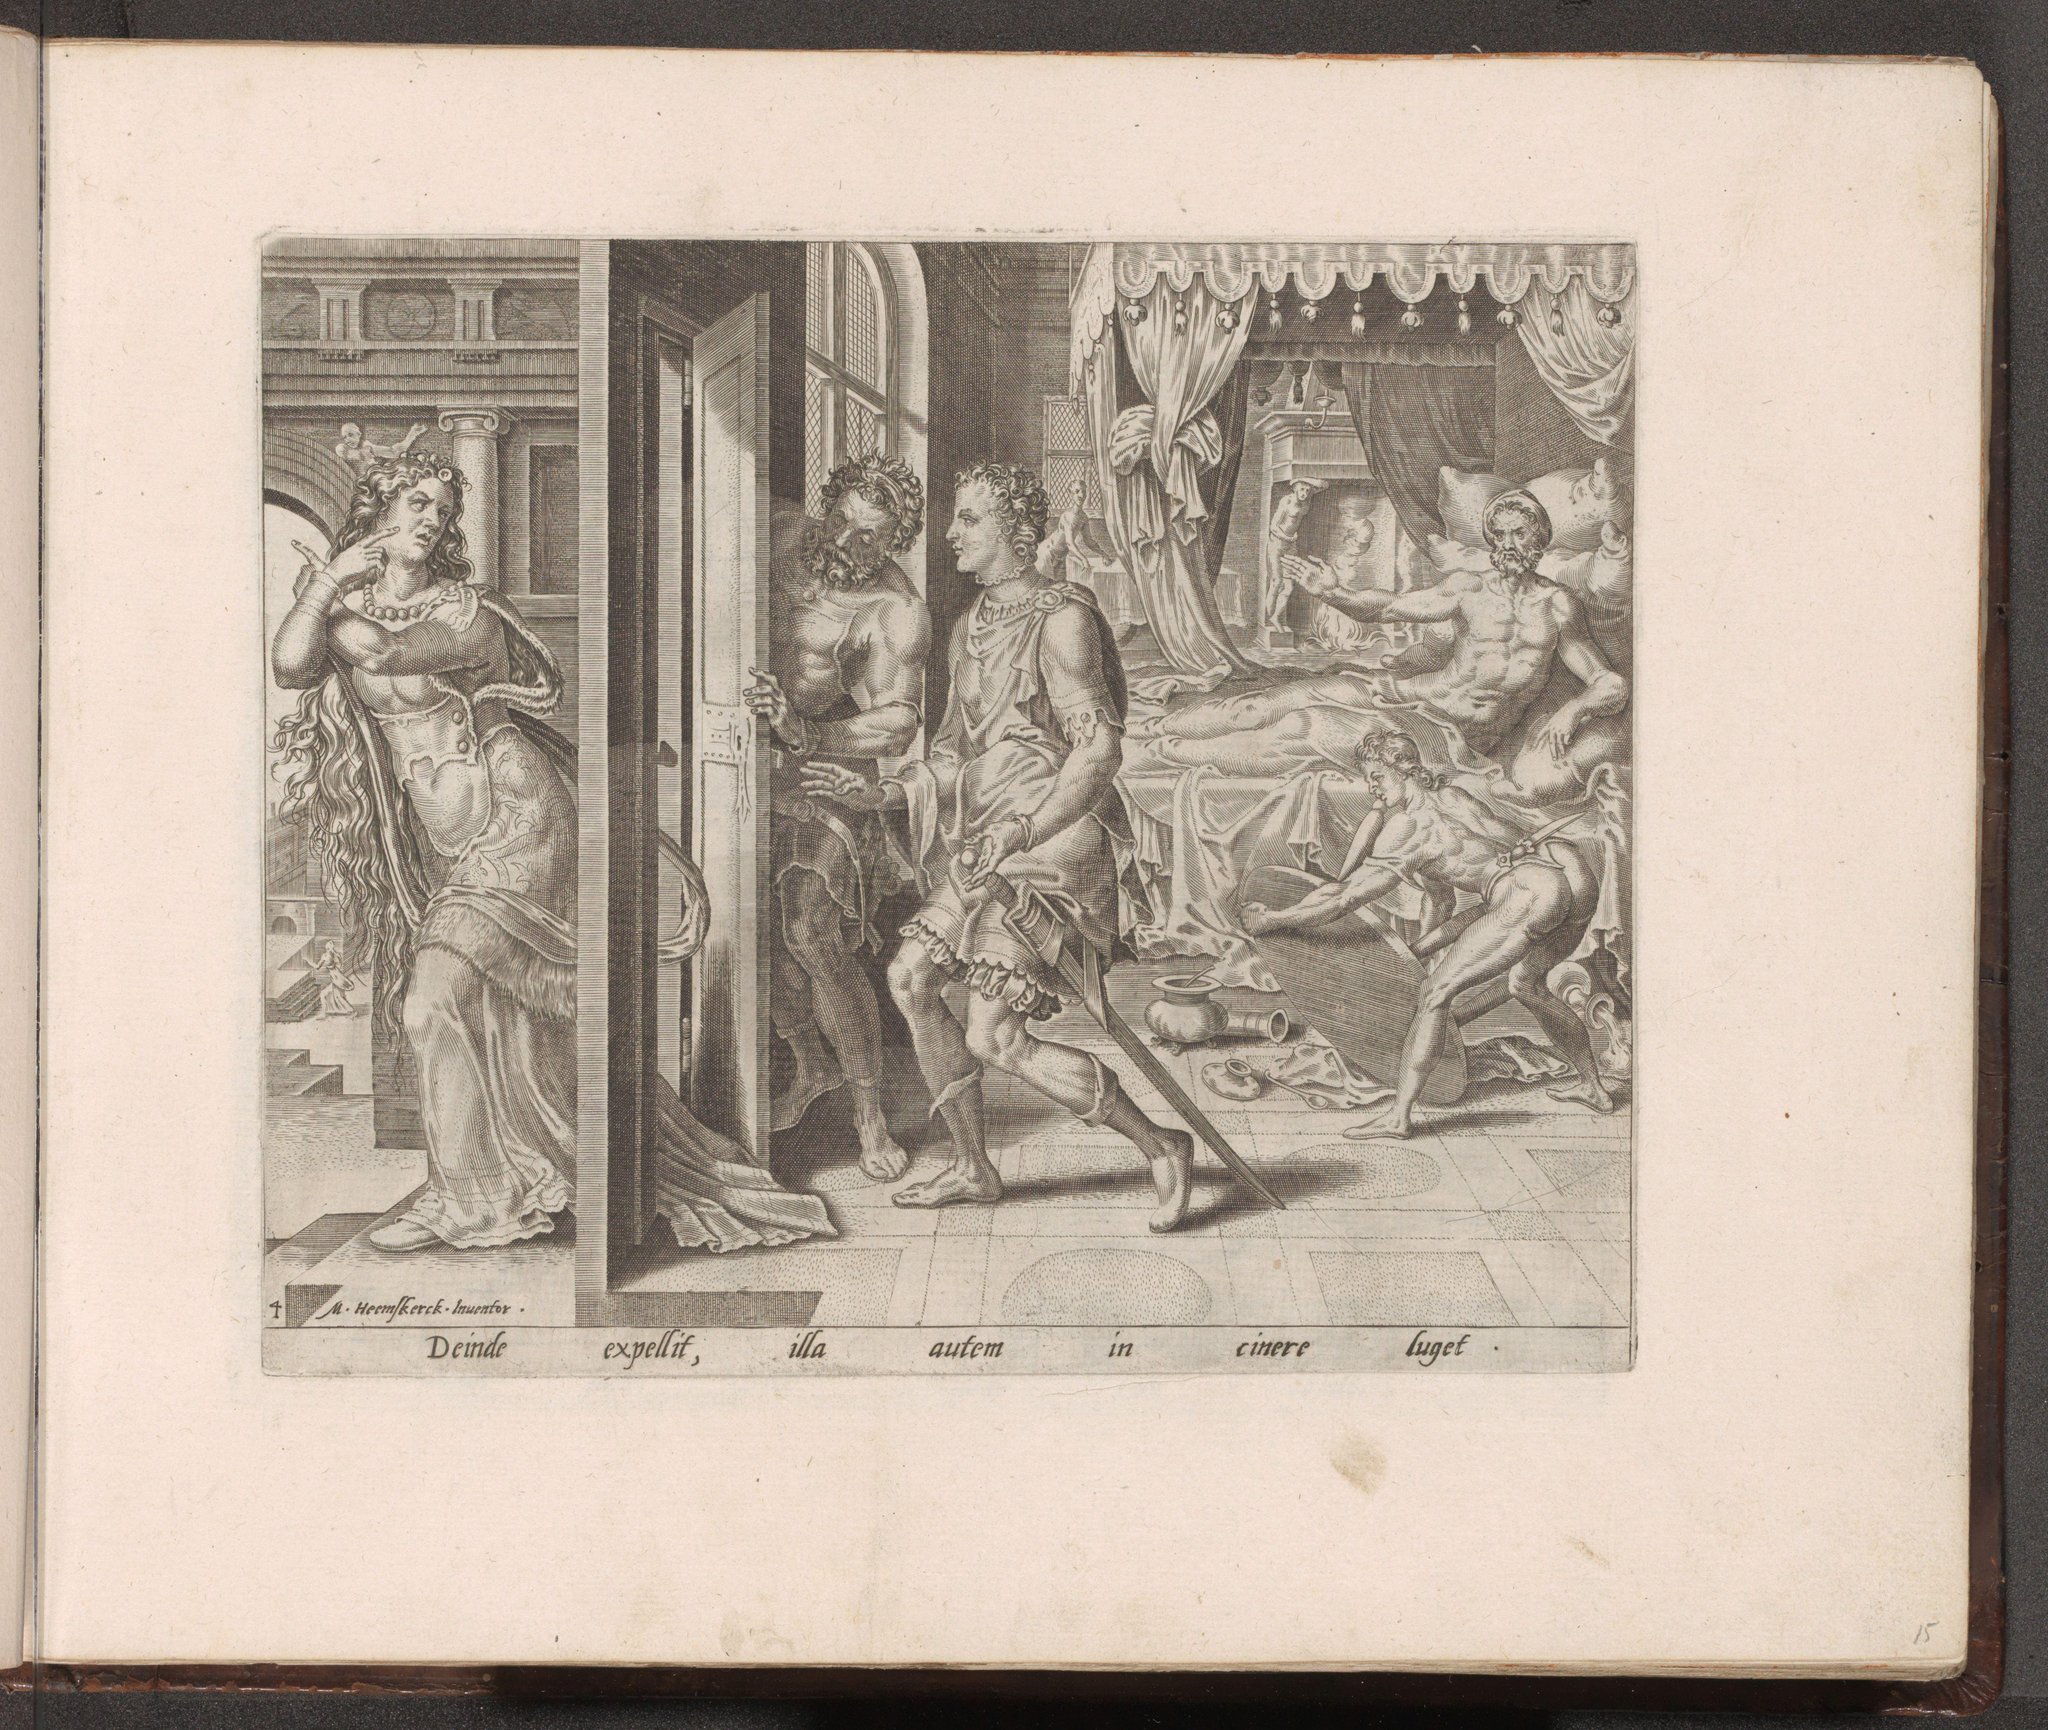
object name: album leaf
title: Thesaurus sacrarum historiaru[m] veteris testame[n]ti, elega[n]tissimis imaginibus expressu[m] excelle[n]tissimoru[m] in hac arte viroru[m] opera: nu[n]c primu[m] in luce[m] editus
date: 1559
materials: paper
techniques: engraving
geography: antwerp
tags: amnon sends tamar away; tamar puts ashes on her head, rends her garment, lays her hand on her head and leaves crying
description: Nadat Amnon zijn halfzus Tamar heeft verkracht voelt hij een diepe haat voor haar en stuurt haar weg. Tamar smeekt hem haar niet weg te sturen, maar Amnon geeft met een wijzend gebaar zijn bedienden de opdracht om haar uit huis te zetten en de deur achter haar op slot te doen. Een bediende ruimt de omgevallen tafel naast het bed op. Onder de voorstelling een verwijzing in het Latijn naar de Bijbeltekst. Prent maakt deel uit van een album.